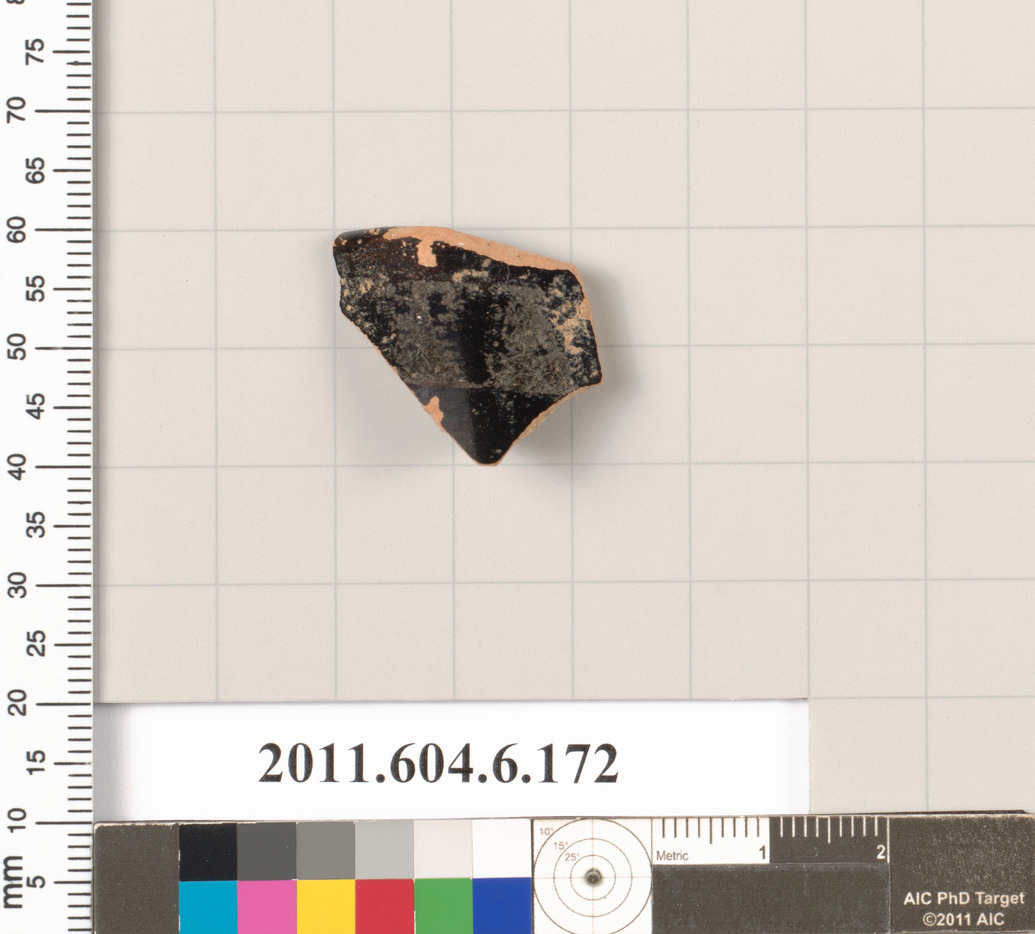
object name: oinochoe fragment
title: Terracotta fragment of an oinochoe (jug)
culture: greek, attic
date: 500-401 BCE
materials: terracotta